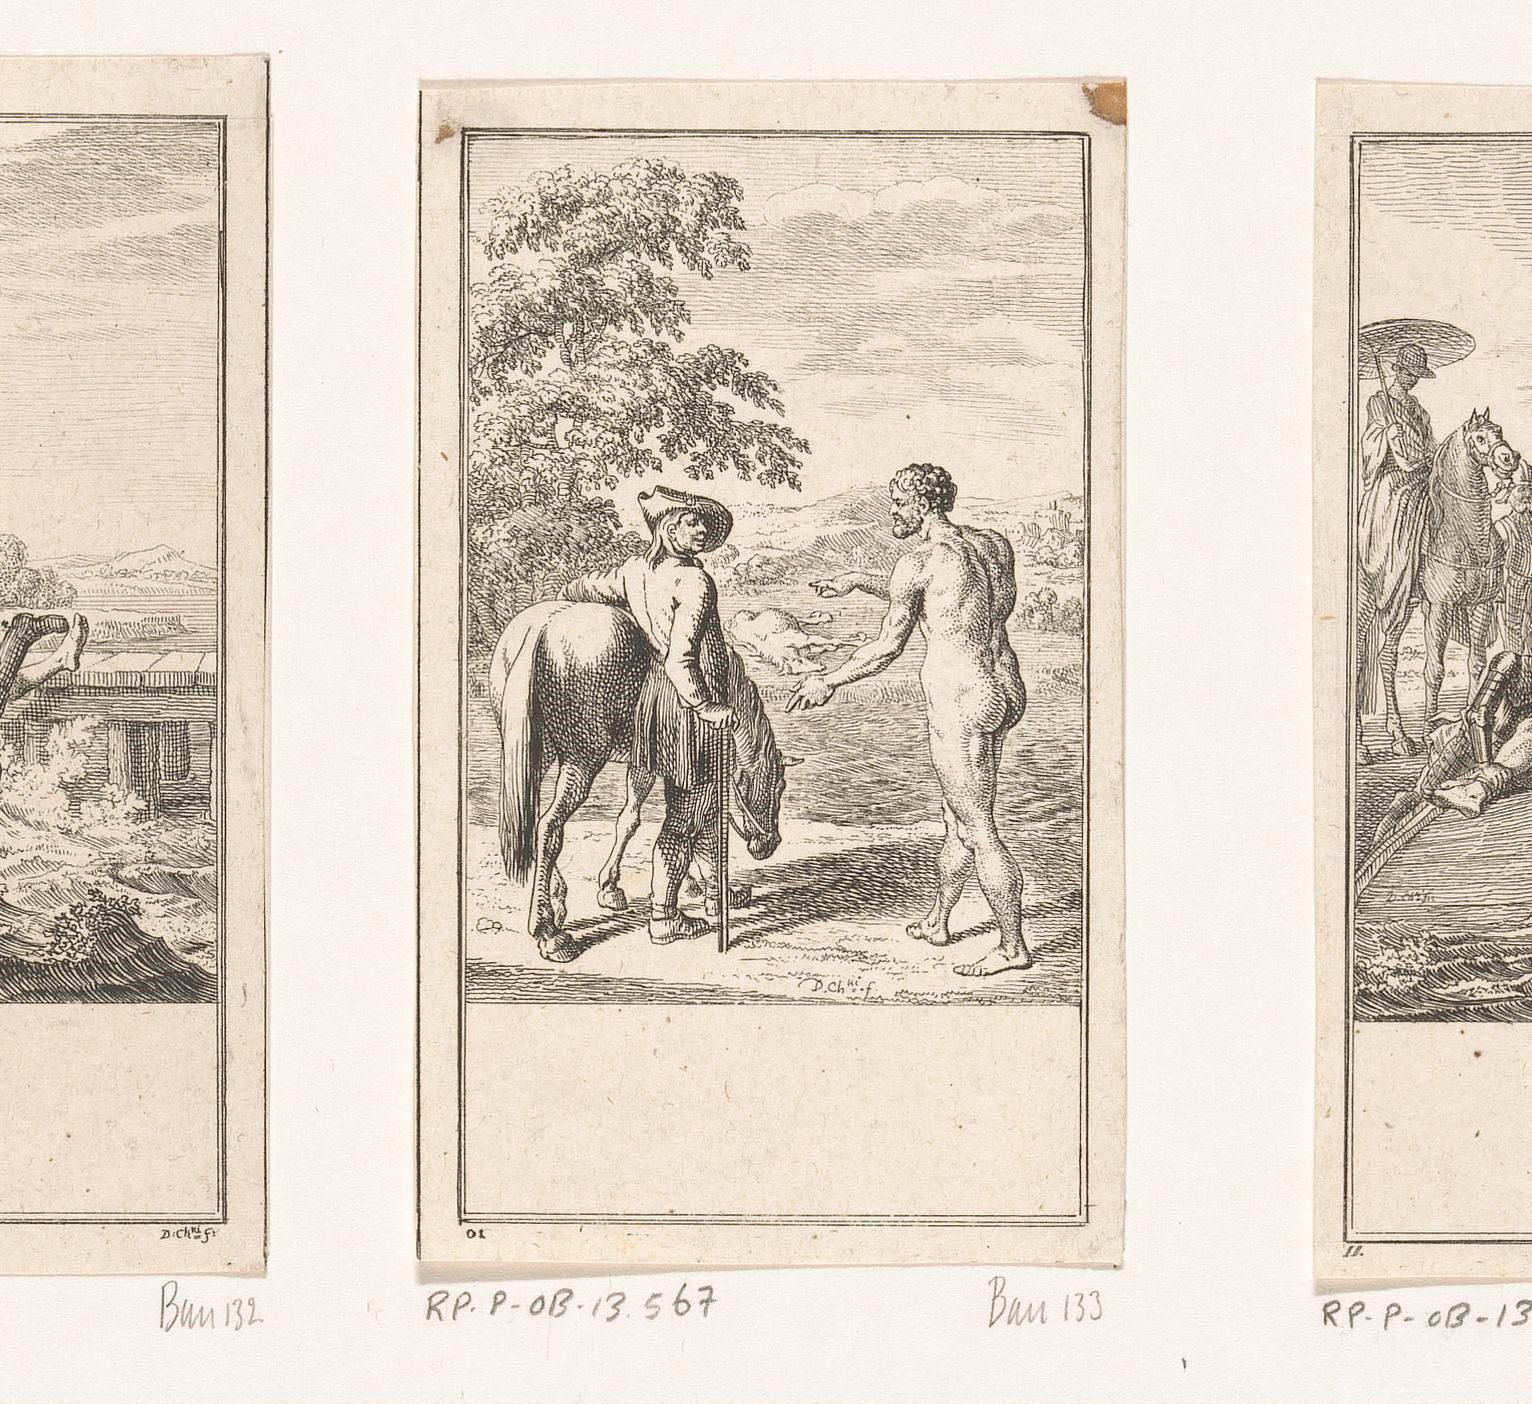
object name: print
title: Ariosto probeert zijn paard te ruilen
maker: daniel nikolaus chodowiecki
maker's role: draughtsman, print maker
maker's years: 1726-1801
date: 1771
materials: paper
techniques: etching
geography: berlin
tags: ludovico ariosto, (scenes from) specific works of literature: ariosto, orlando furioso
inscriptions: collector's mark: Lugt 240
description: Canto dertig uit 'Ariosto Furioso'. Na dagenlang gereden te hebben zonder rust of eten sterft het paard van Ariosto. Met een herder probeert Ariosto het dode dier te ruilen voor een gezond exemplaar. Als deze weigert slaat Ariosto zijn hersens in. Linksonder genummerd: 10.